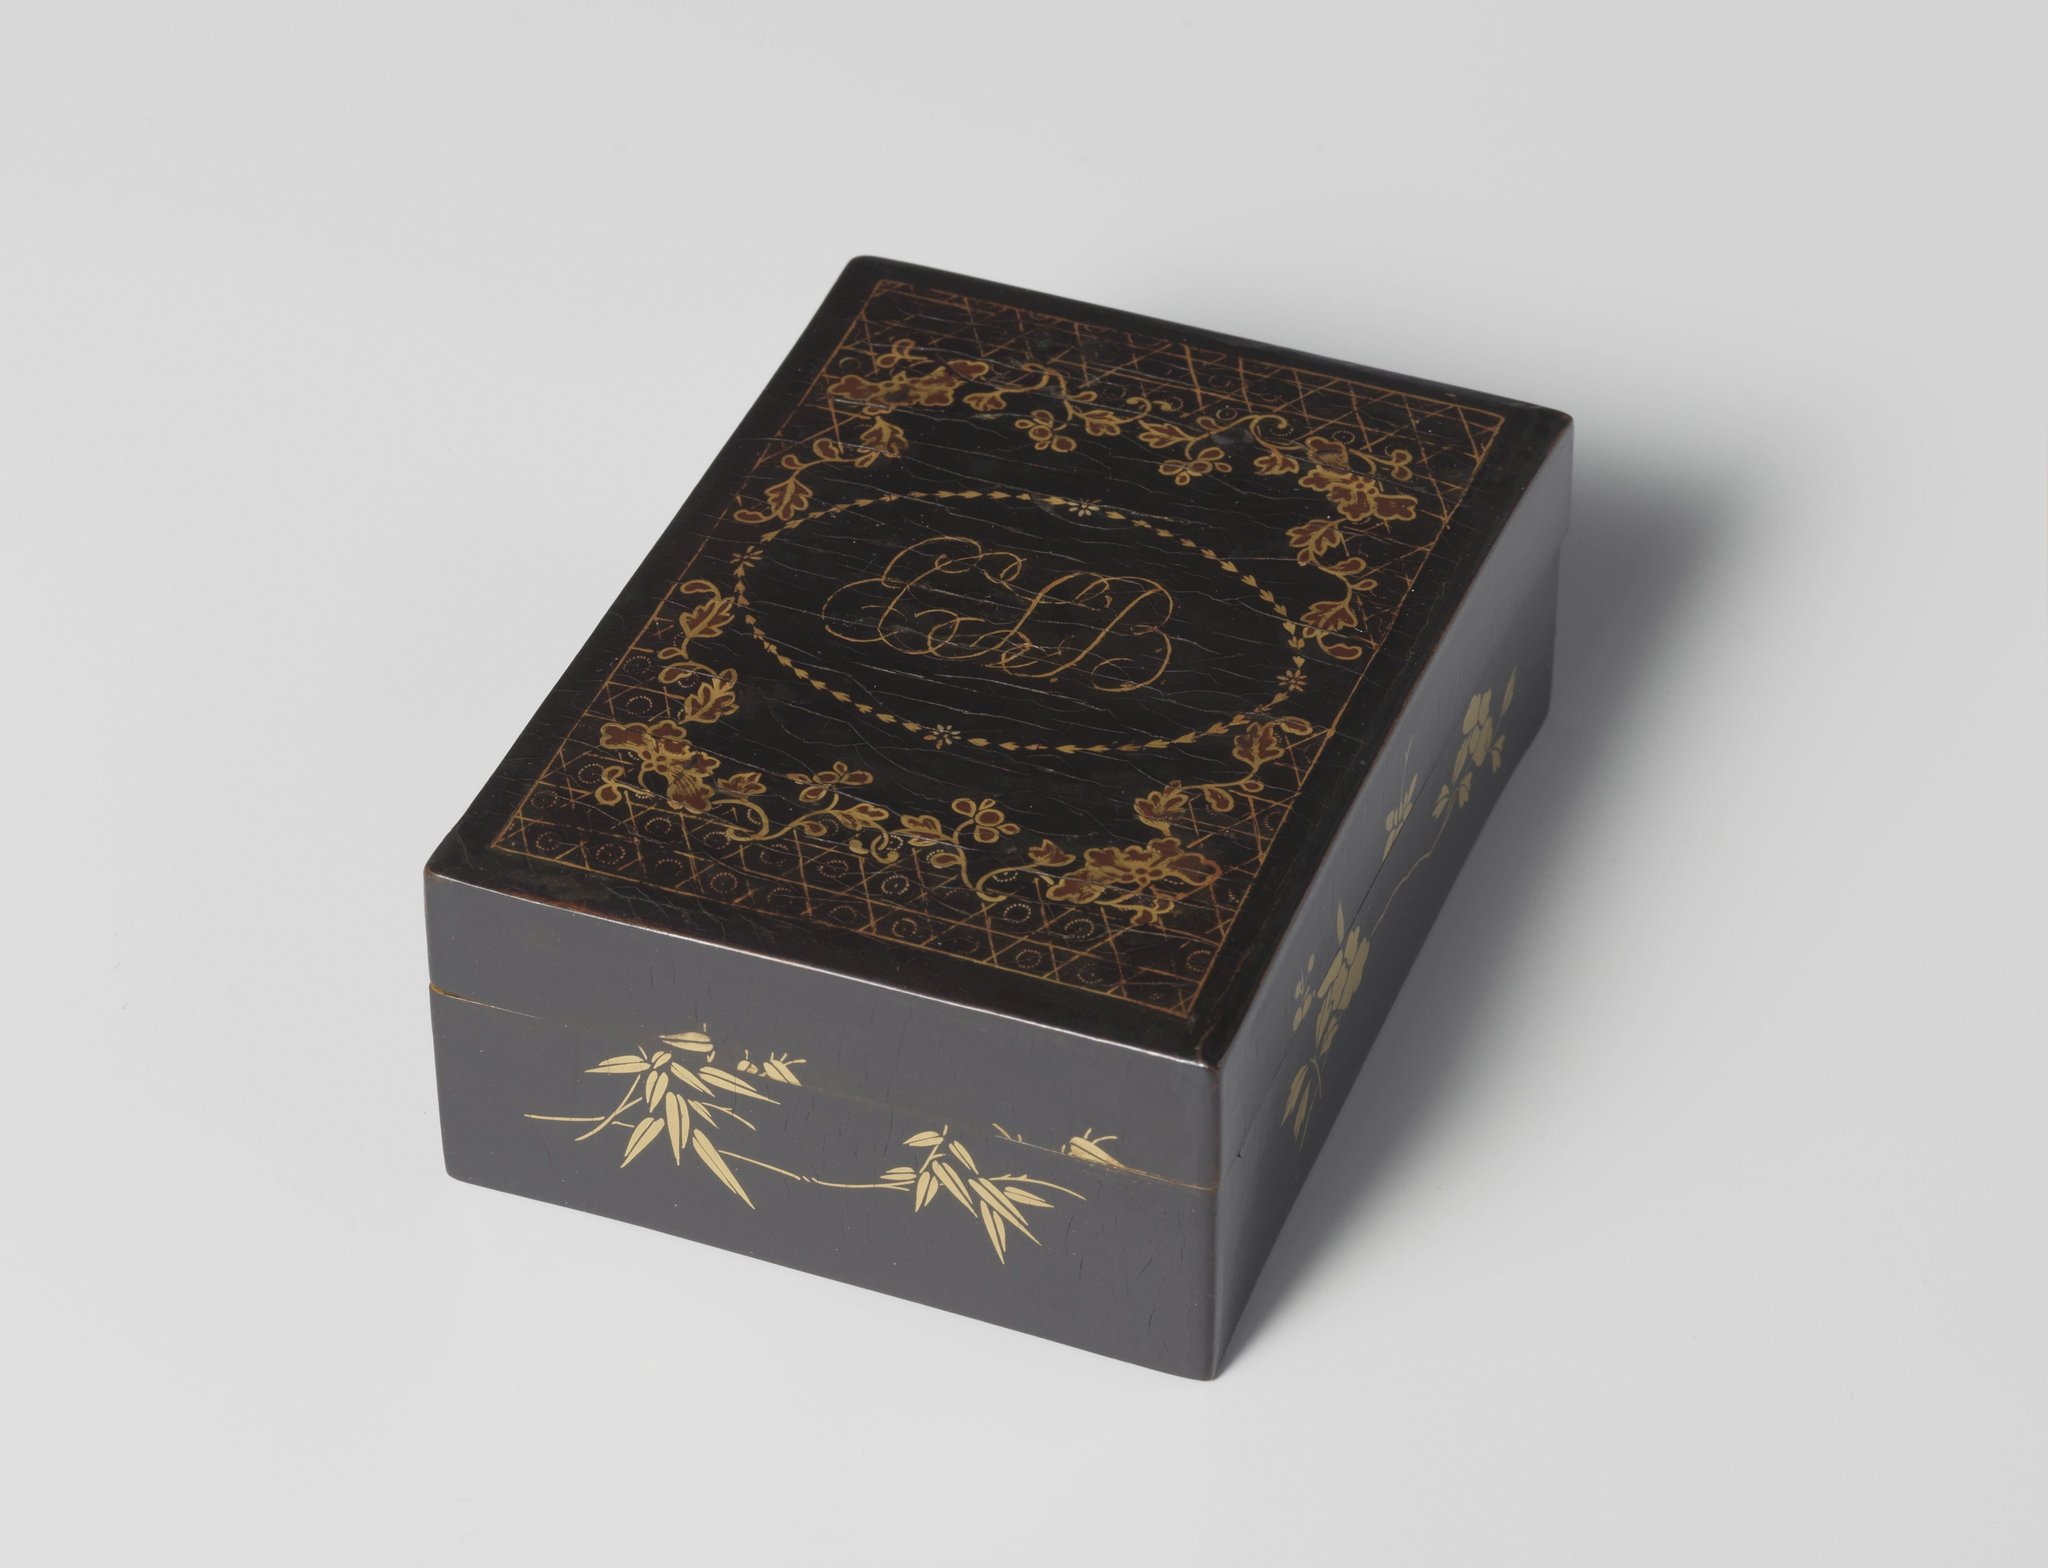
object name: dressing case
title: Toilet Set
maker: Anonymous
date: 1795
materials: lacquer, wood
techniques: lacquer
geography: guangdong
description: The most important element of this toilet set is the Chinese lacquerwork, which was very popular in Europe. Everarda Catharina Sophia van Braam Houckgeest received this toilet chest with a mirror as a gift from her father, who had it made in Canton, China. Her initials are visible on the accompanying toilet boxes.